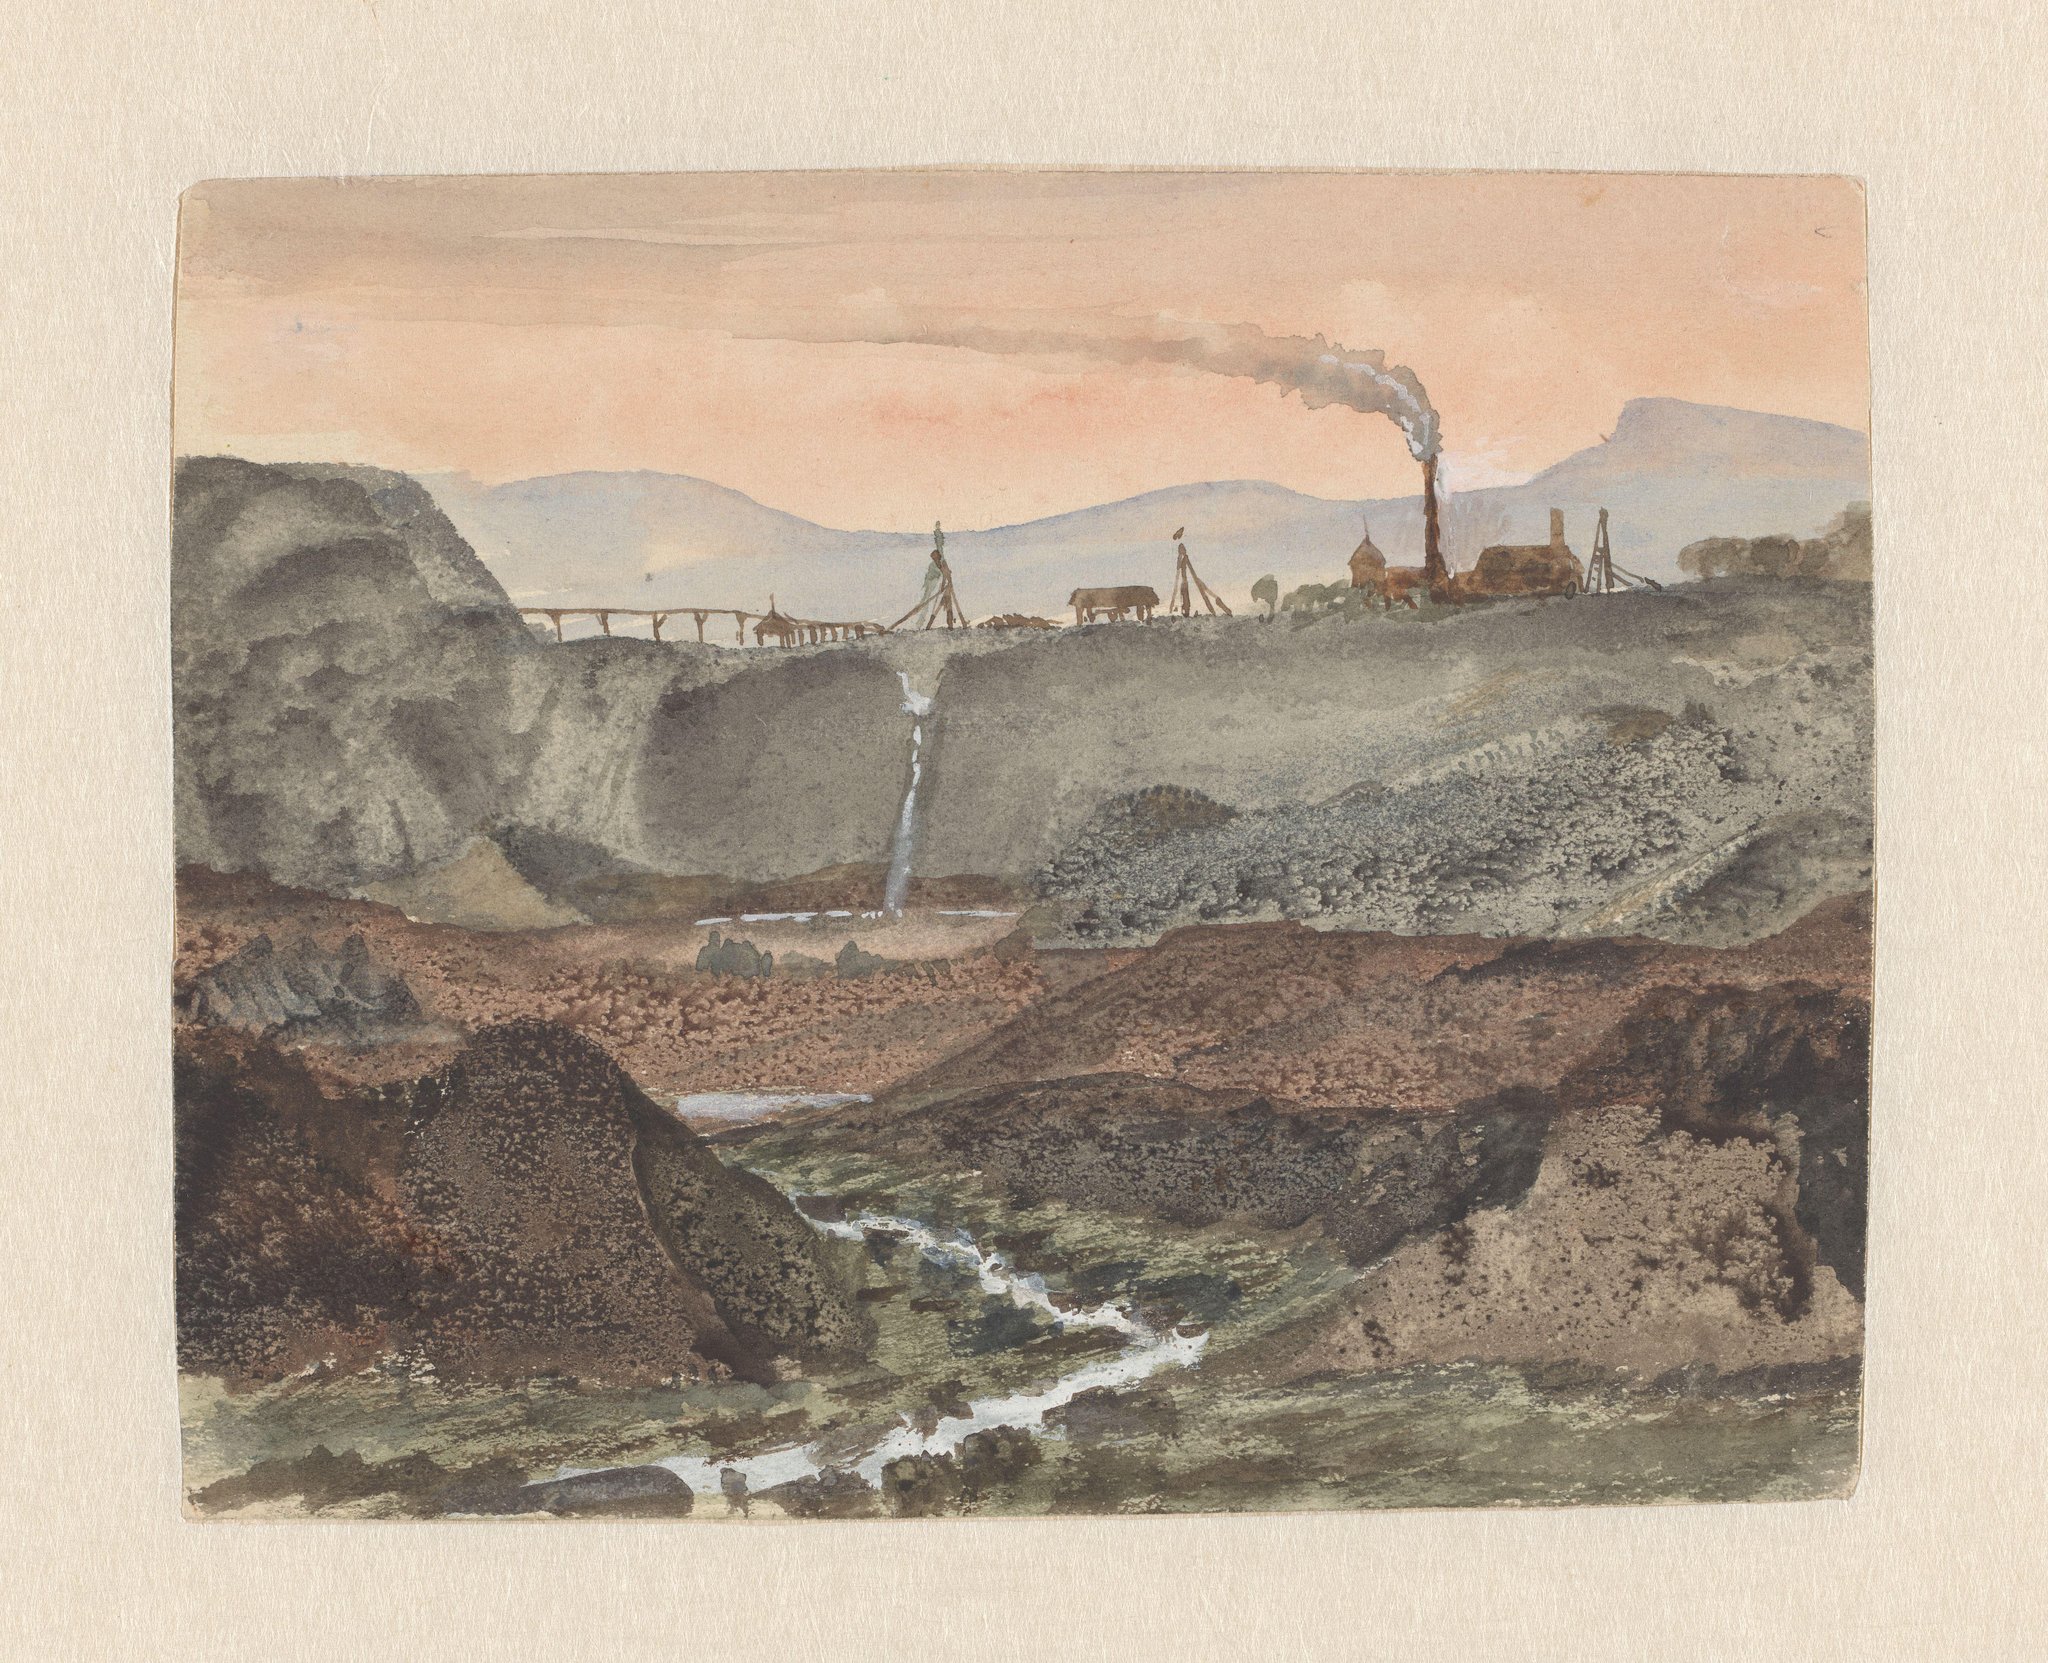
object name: drawing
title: Landschap met fabrieken in Montluçon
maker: george sand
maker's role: schrijver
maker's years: 1804-1876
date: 1861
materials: paint, paper, watercolor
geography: montluçon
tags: montluçon